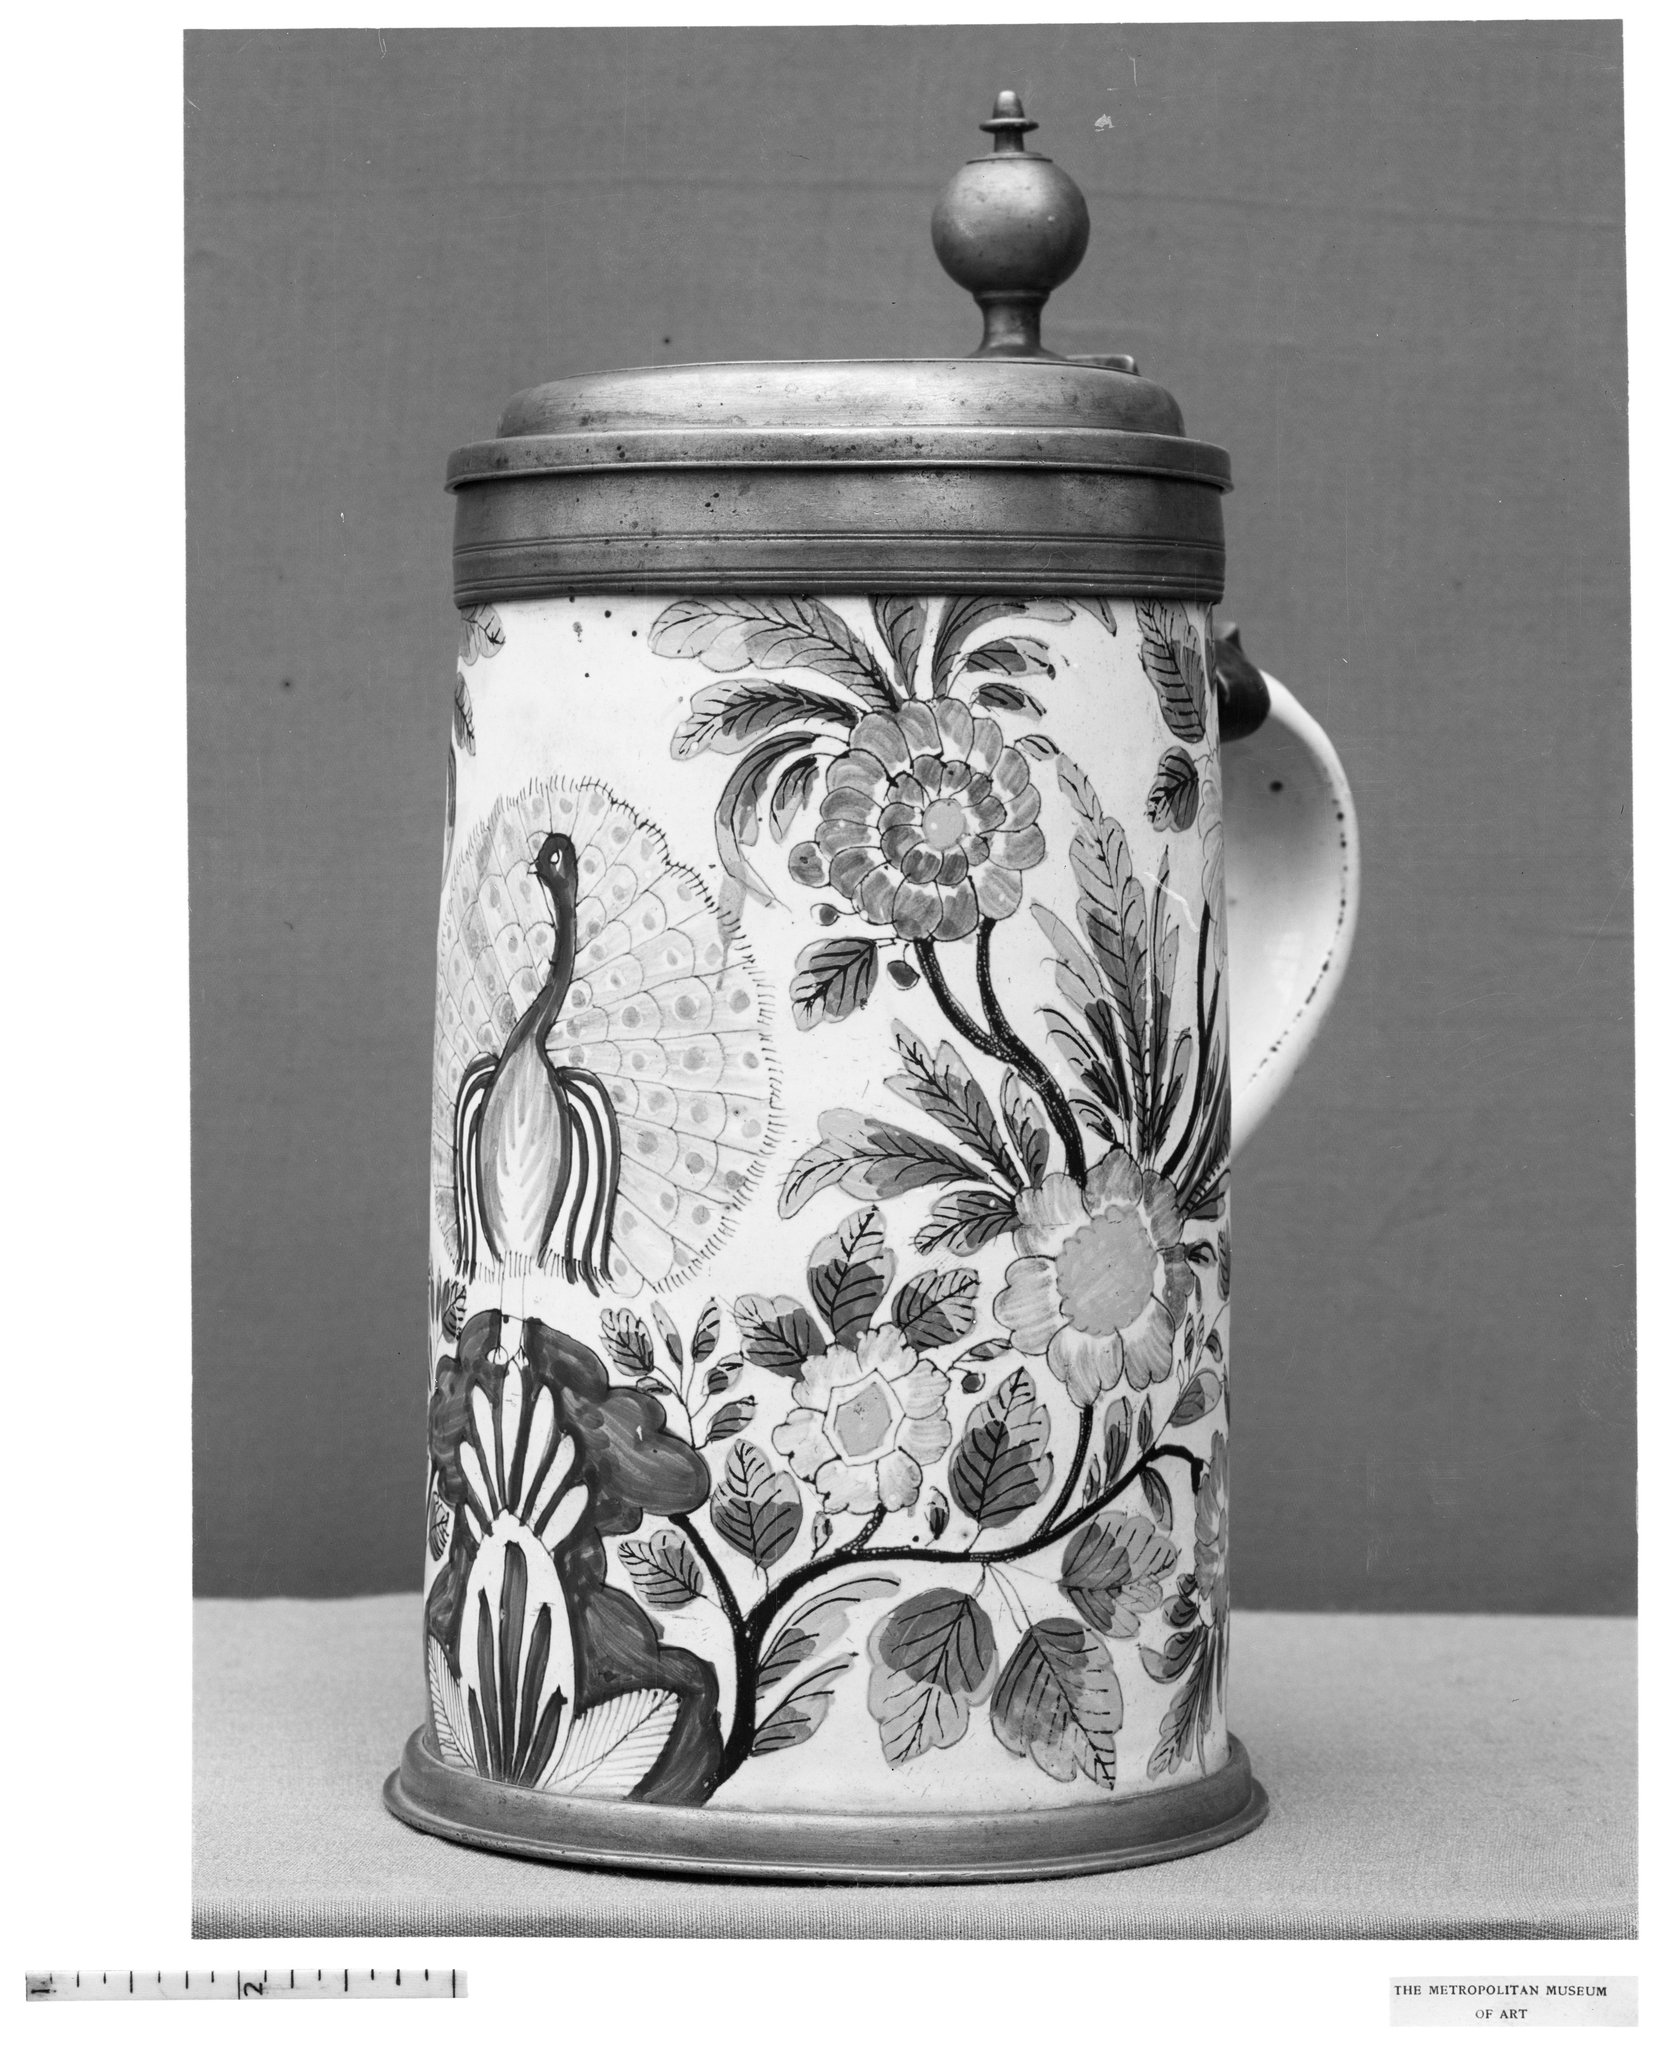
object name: tankard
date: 1701-1800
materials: earthenware, pewter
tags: peacocks,flowers